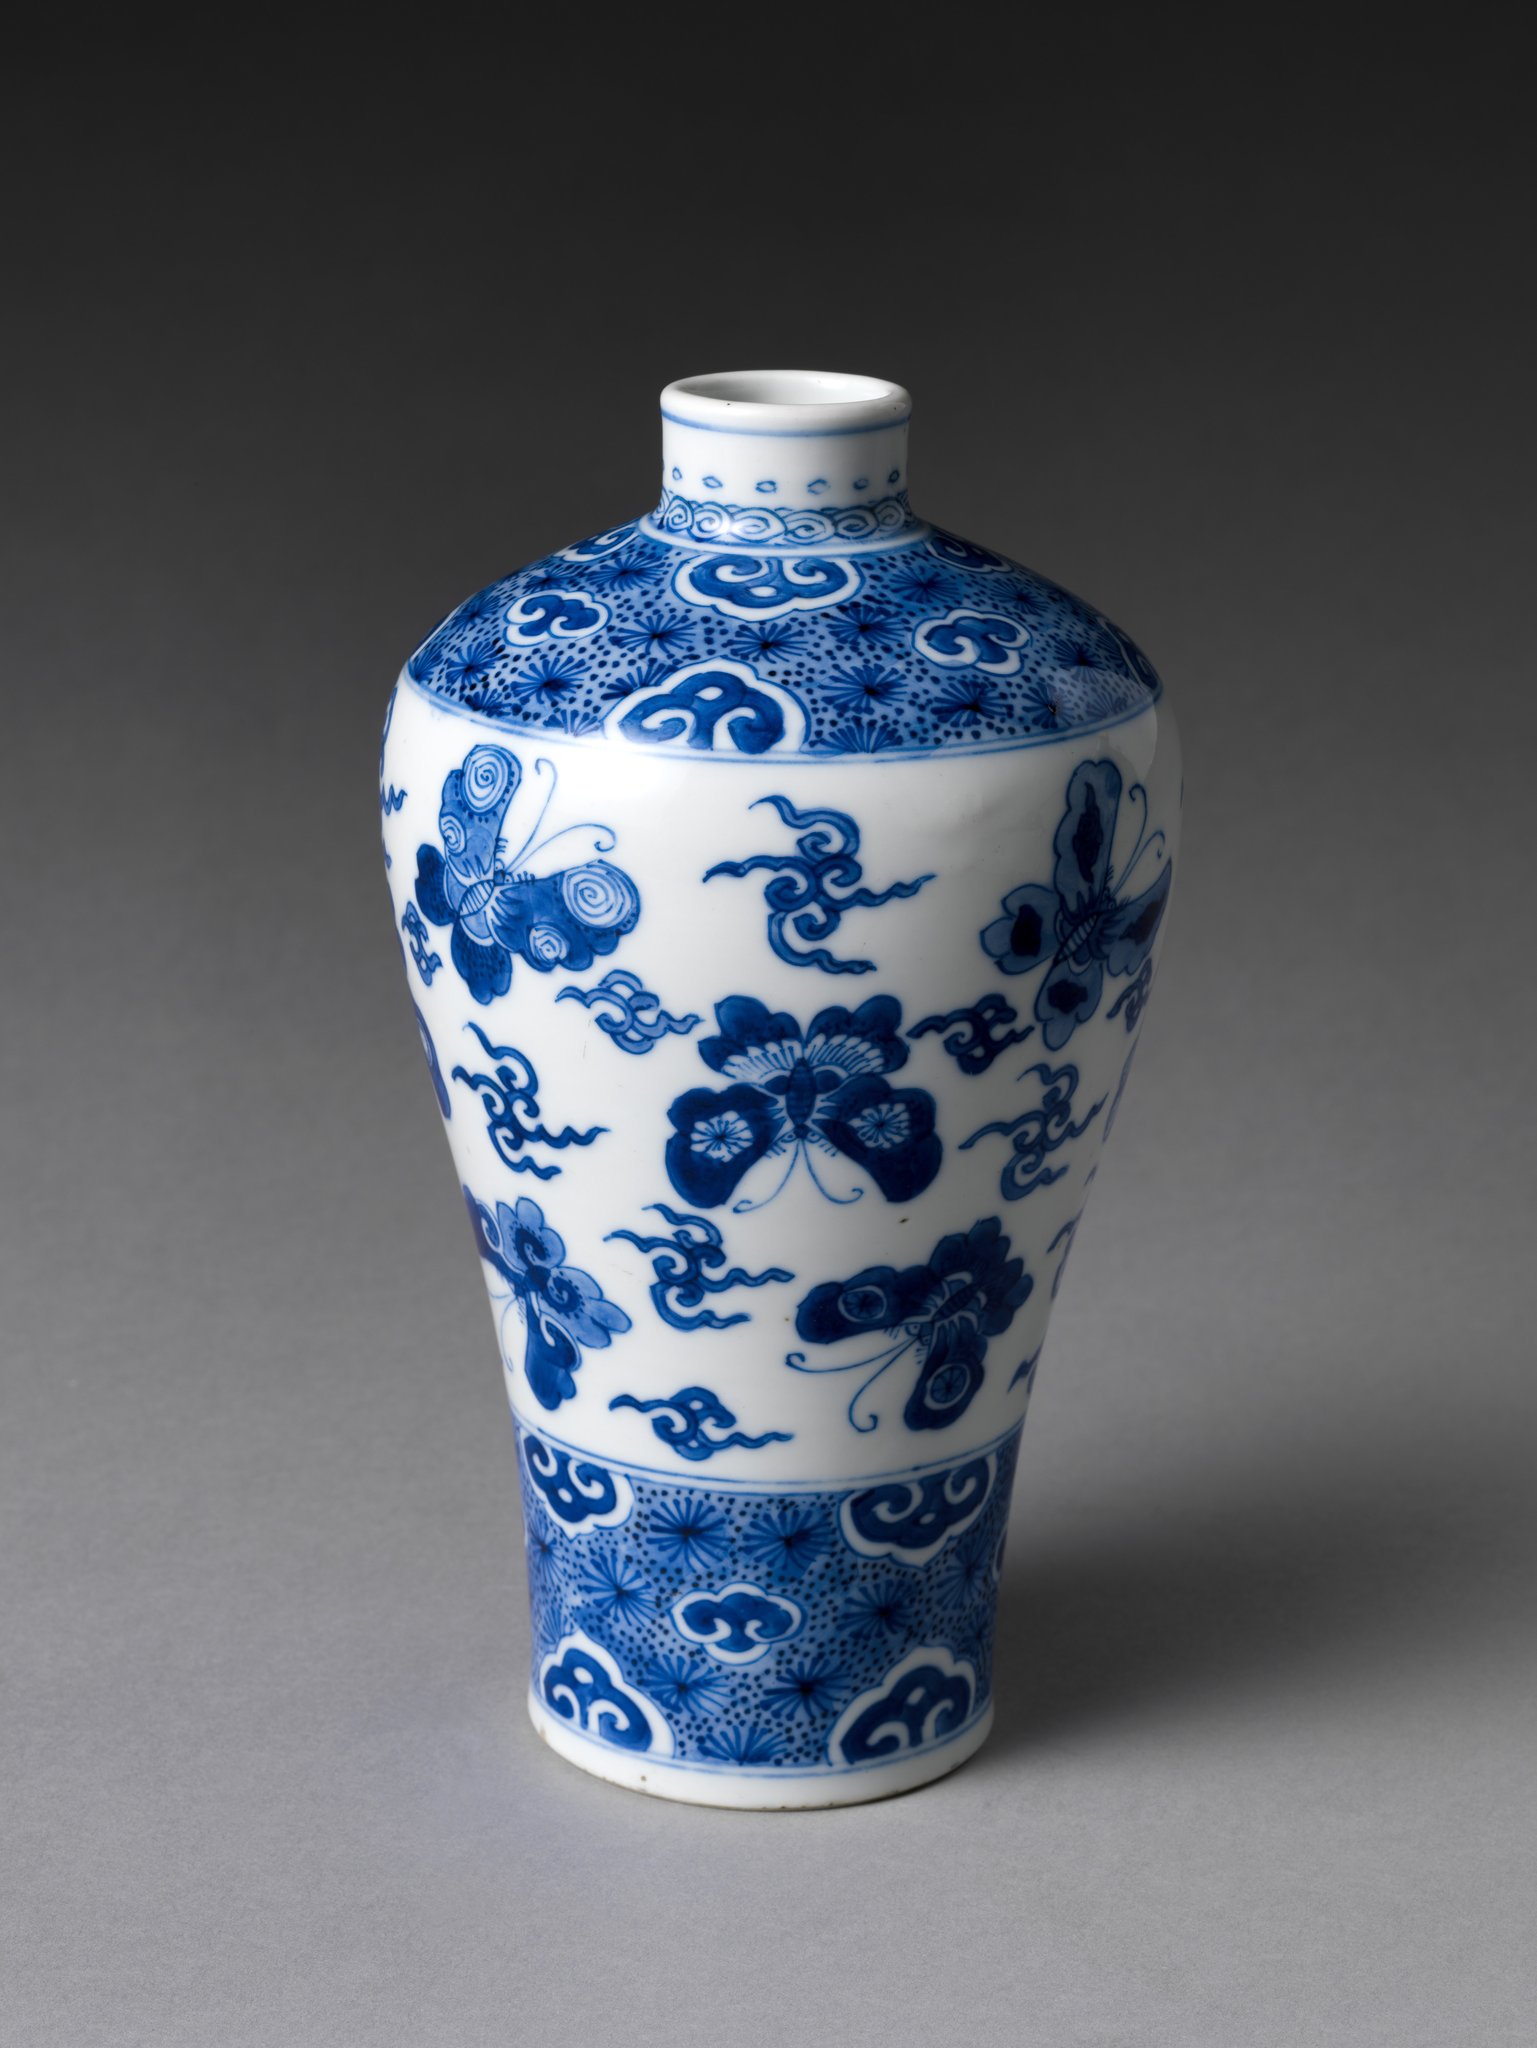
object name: vase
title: Vase with Butterflies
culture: chinese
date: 1667-1733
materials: cobalt, glaze, porcelain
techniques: painting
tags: butterflies